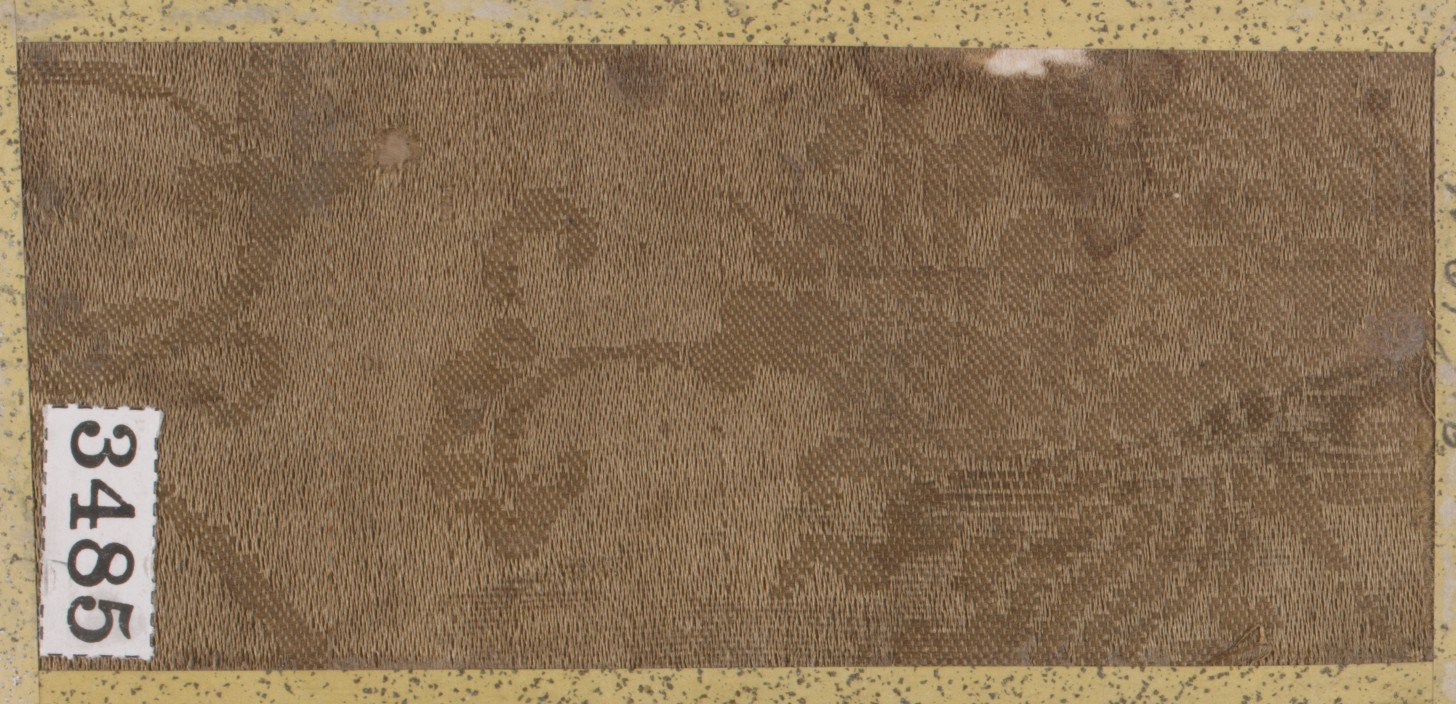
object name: sample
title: Textile Sample from Sample Book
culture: japanese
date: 1801-1900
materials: silk